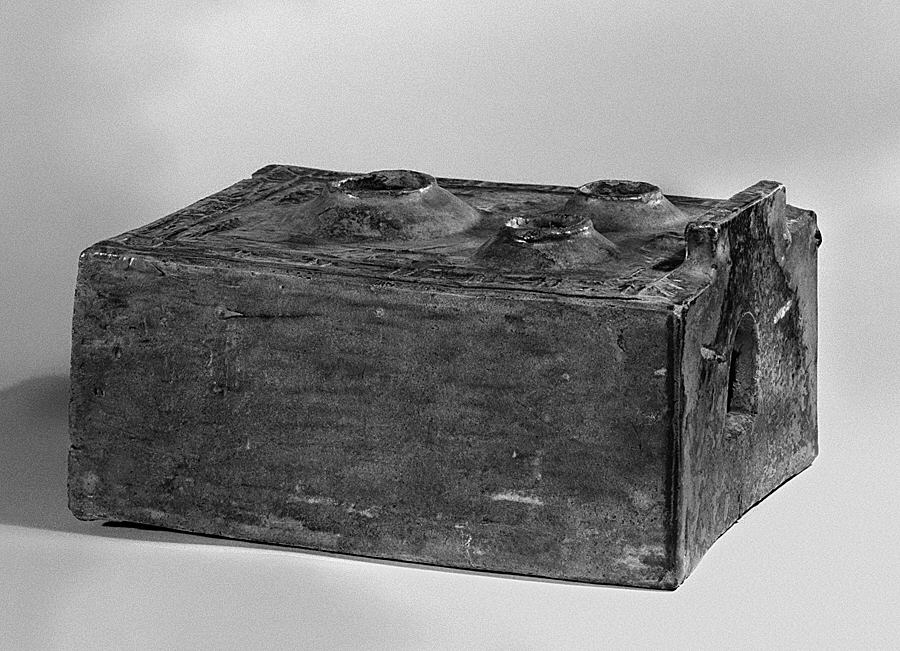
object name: stove model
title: Model of a stove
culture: chinese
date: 1-200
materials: earthenware, glaze